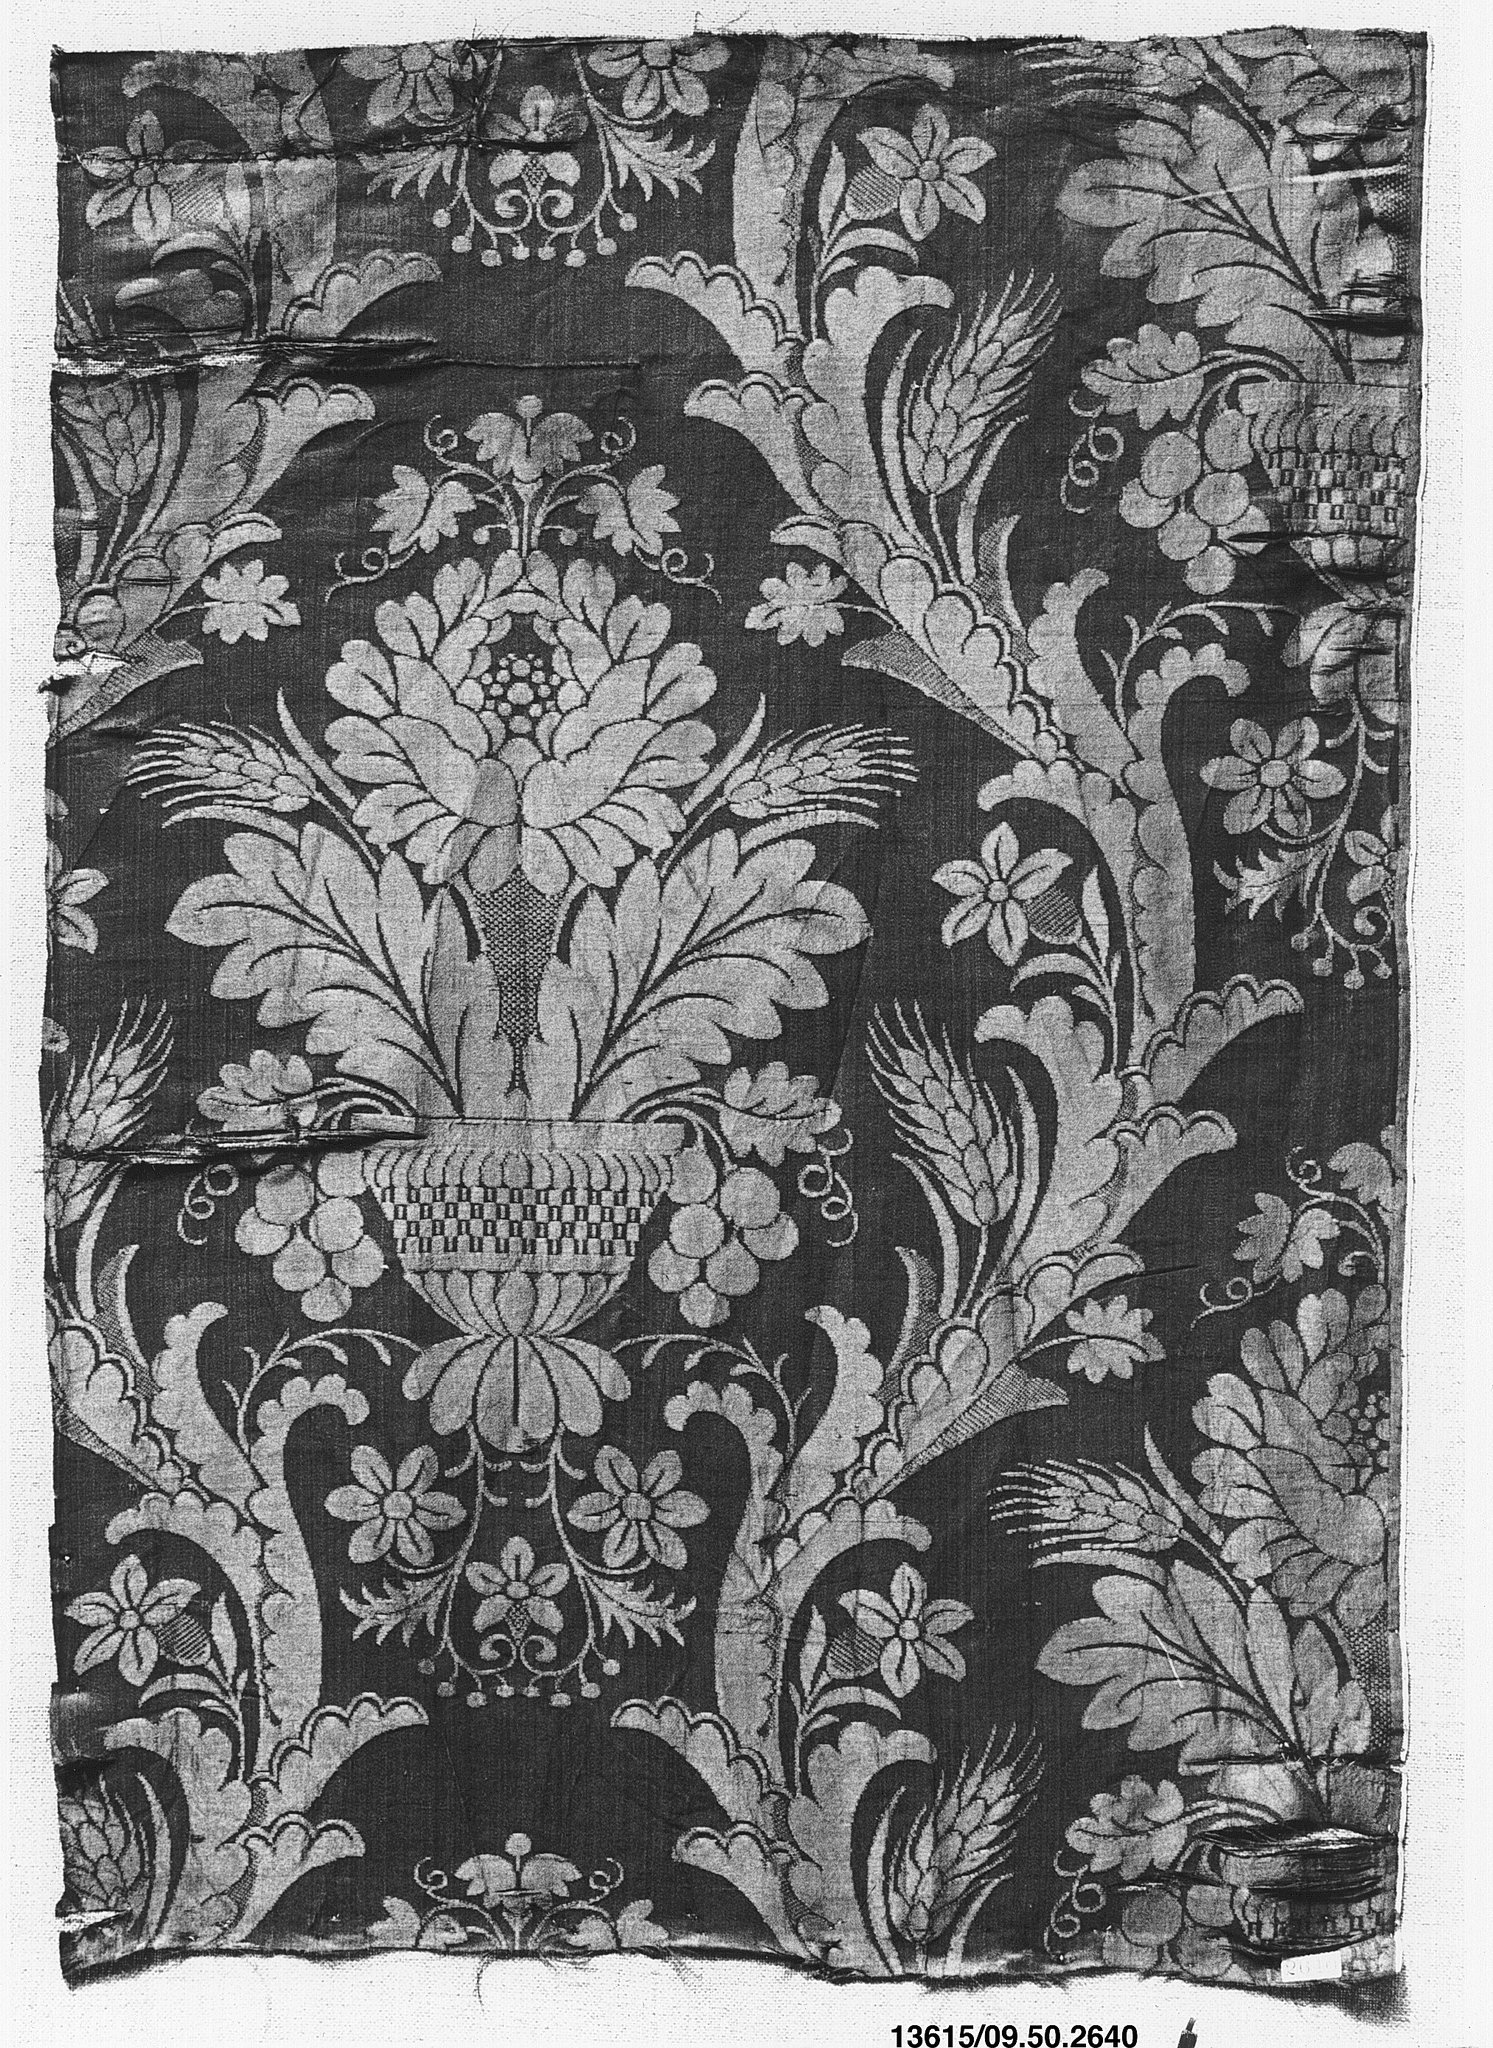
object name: piece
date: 1701-1800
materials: silk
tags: flowers,leaves